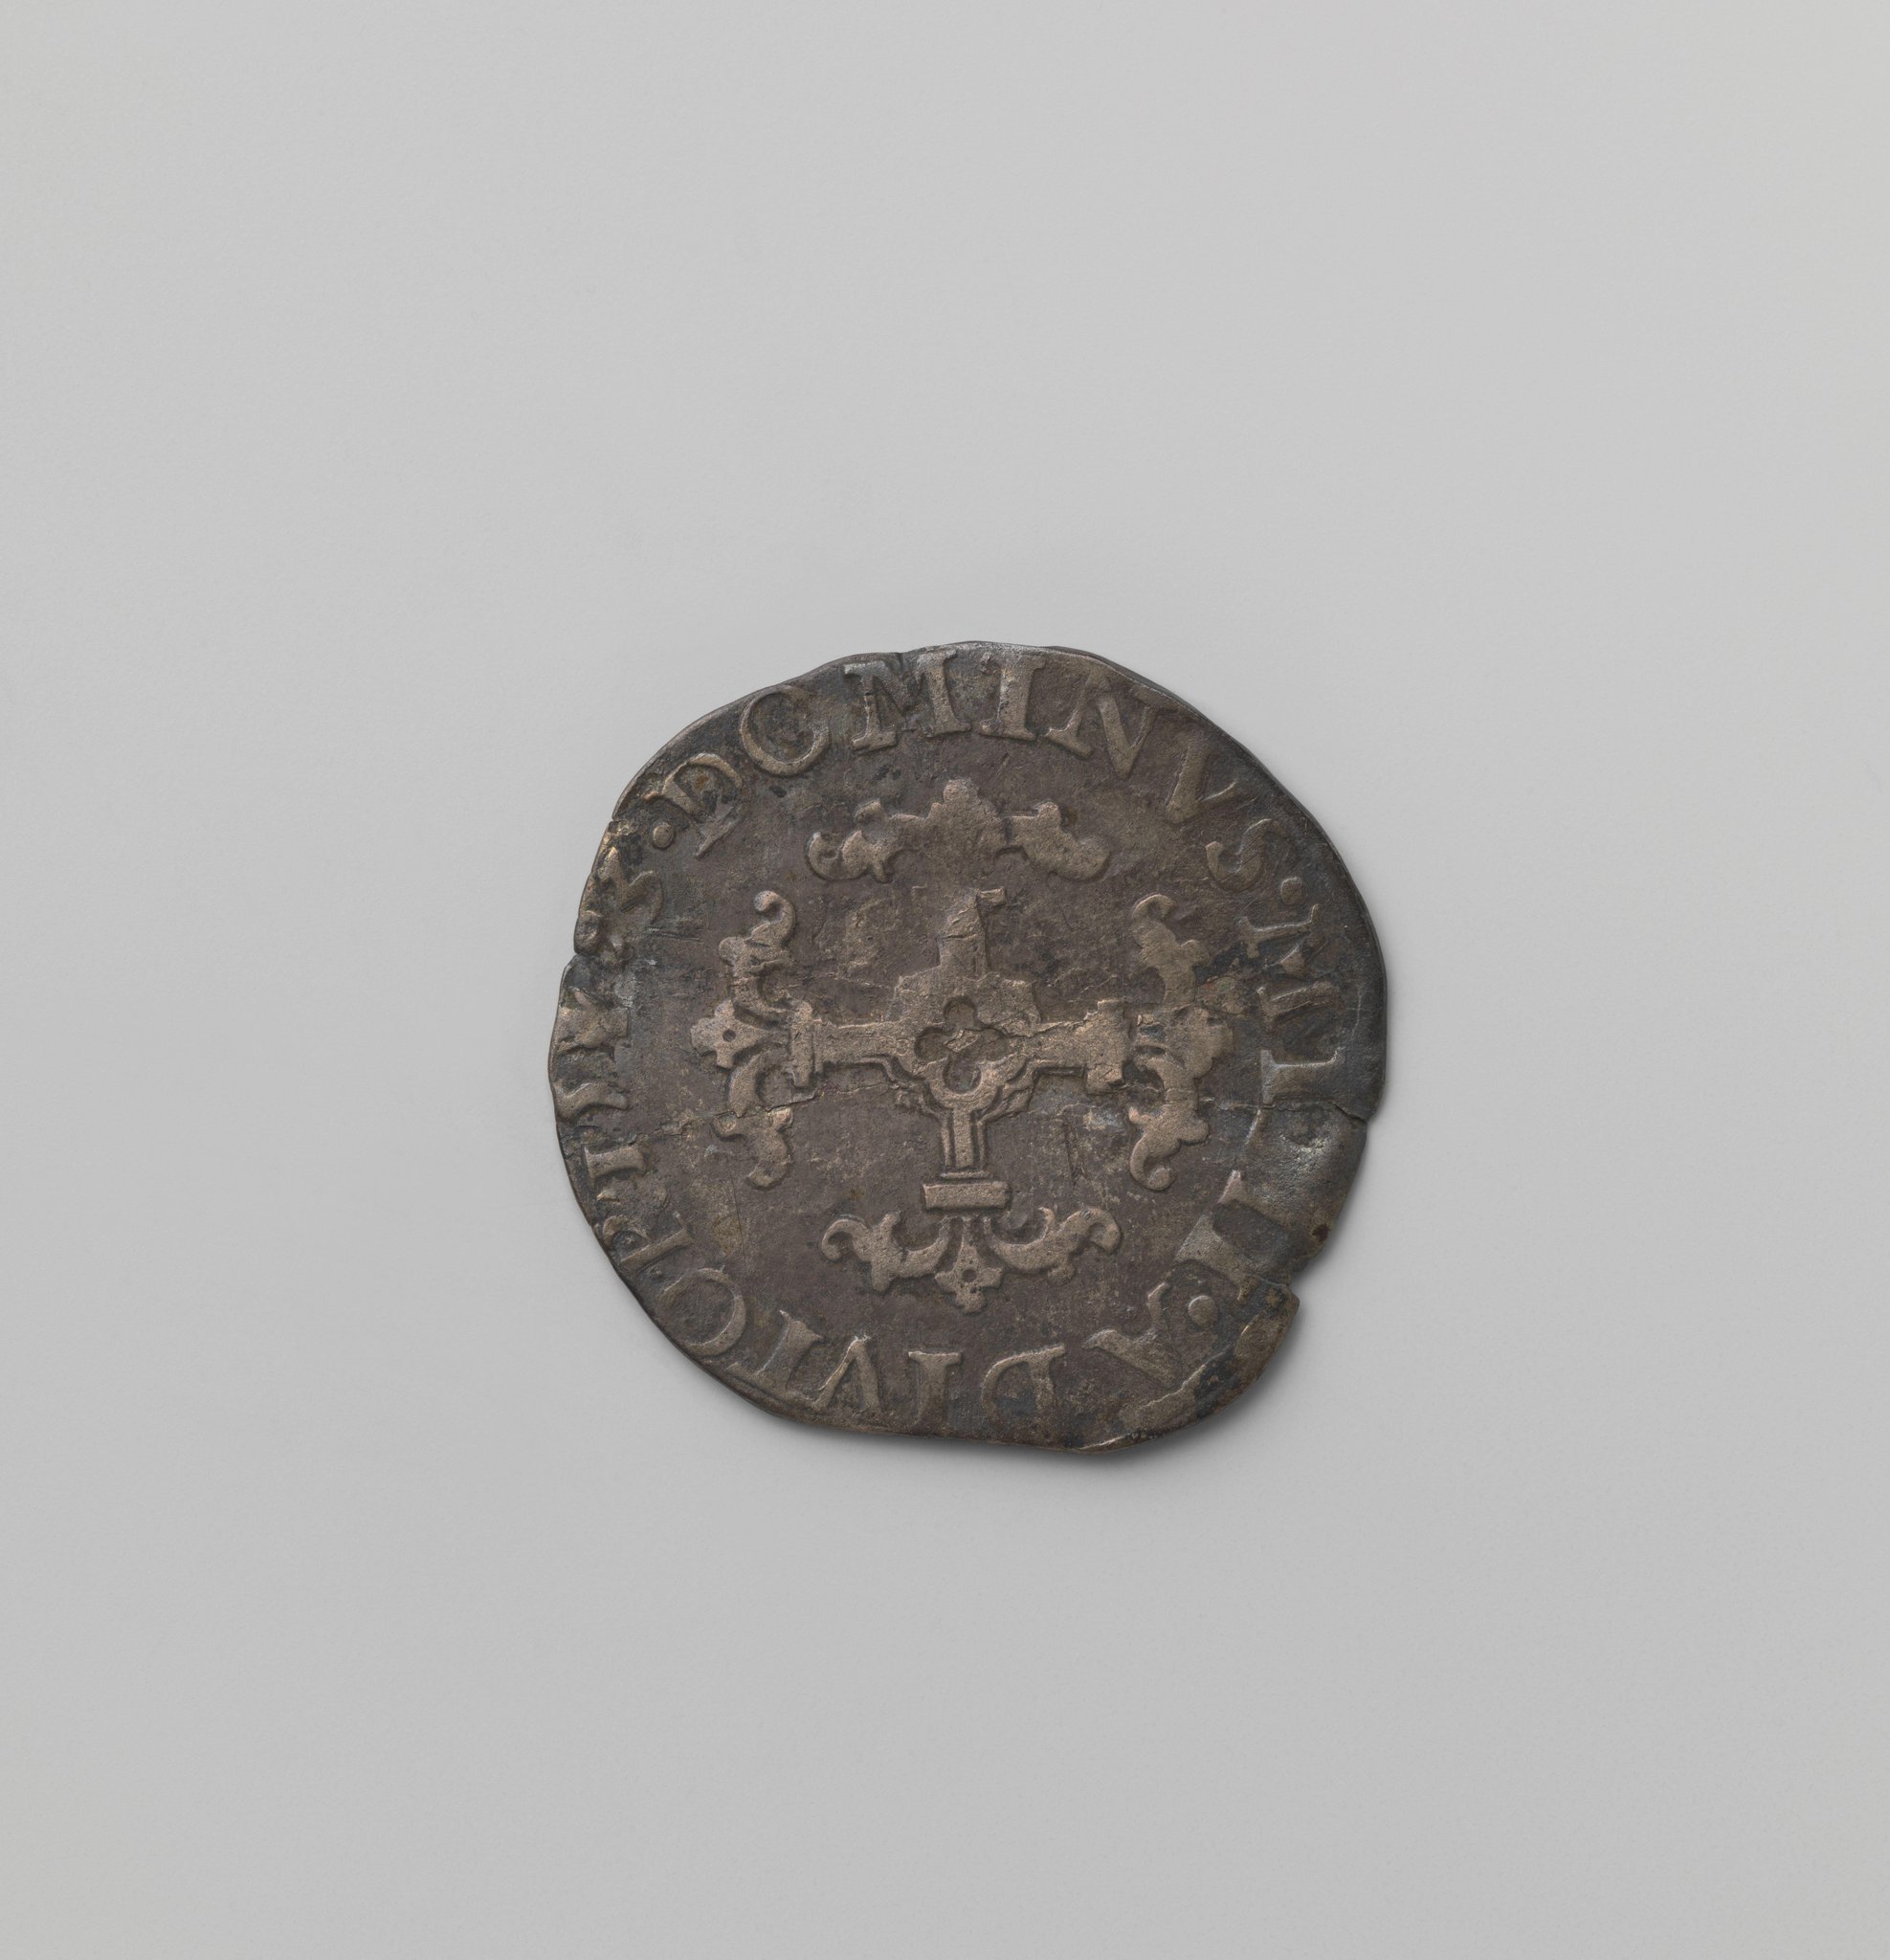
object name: coin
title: Brabant, Philips II, twintigste philipsdaalder, 1573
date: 1573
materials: silver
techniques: striking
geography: antwerp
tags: philip ii of spain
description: Zilveren munt. Voorzijde: met de orde van het gulden vlies omhangen gekroond wapenschild. Keerzijde: kort gebloemd kruis. Jaartal, waartussen hand, in omschrift bovenaan.